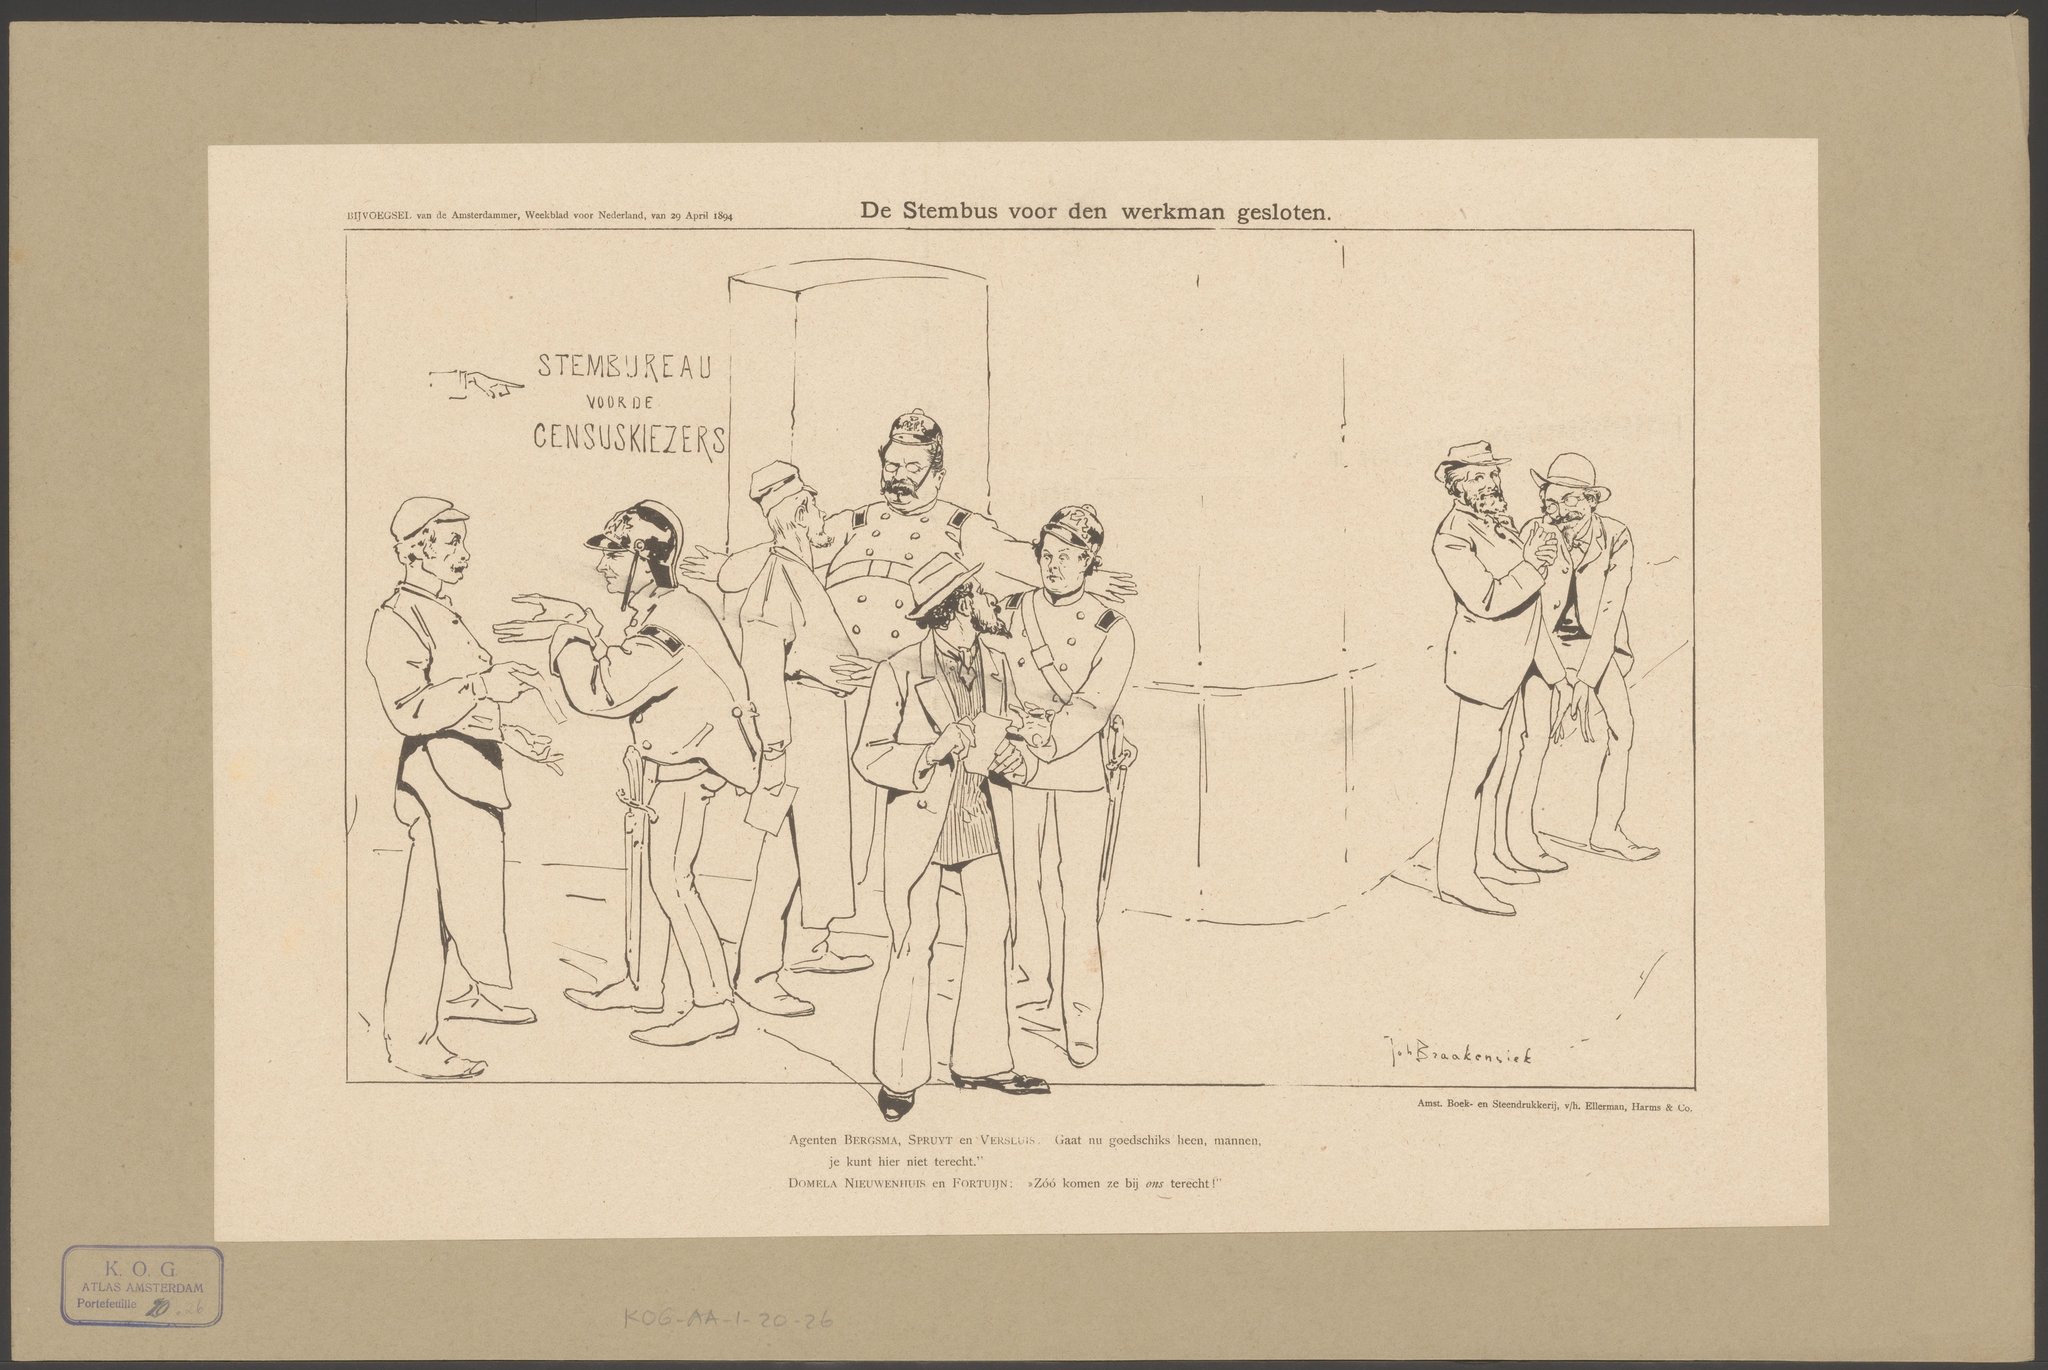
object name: cartoon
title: De Stembus voor den werkman gesloten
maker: johan braakensiek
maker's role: draughtsman, print maker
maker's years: 1858-1940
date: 1894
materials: paper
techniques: lithograph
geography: netherlands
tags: amsterdam, politician, ferdinand domela nieuwenhuis, voting place, polling station, the right to vote, the compulsory vote, policeman, constable, politician, e.g. party leader, political caricatures and satires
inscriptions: collector's mark: Lugt 1641b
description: Bij het stembureau worden door de politieagenten Bergsma, Spruyt en Versluis de werkmannen die willen stemmen weggestuurd. Om de hoek wrijven Domela Nieuwenhuis en Fortuyn van de SDAP zich in de handen omdat ze verwachten dat ze vervolgens bij hen terecht zullen komen. Onderwerpsrubriek binnen de Atlas Amsterdam: Verkiezingen Tweede Kamer.